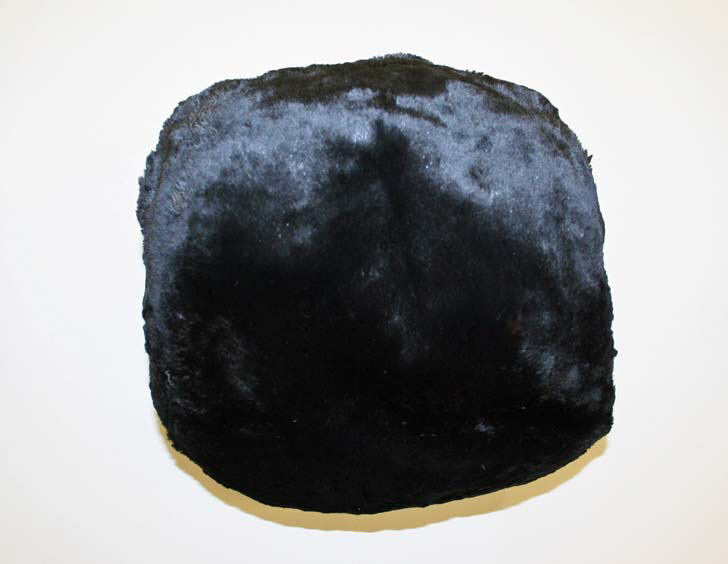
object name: muff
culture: american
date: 1867-1900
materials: fur, silk